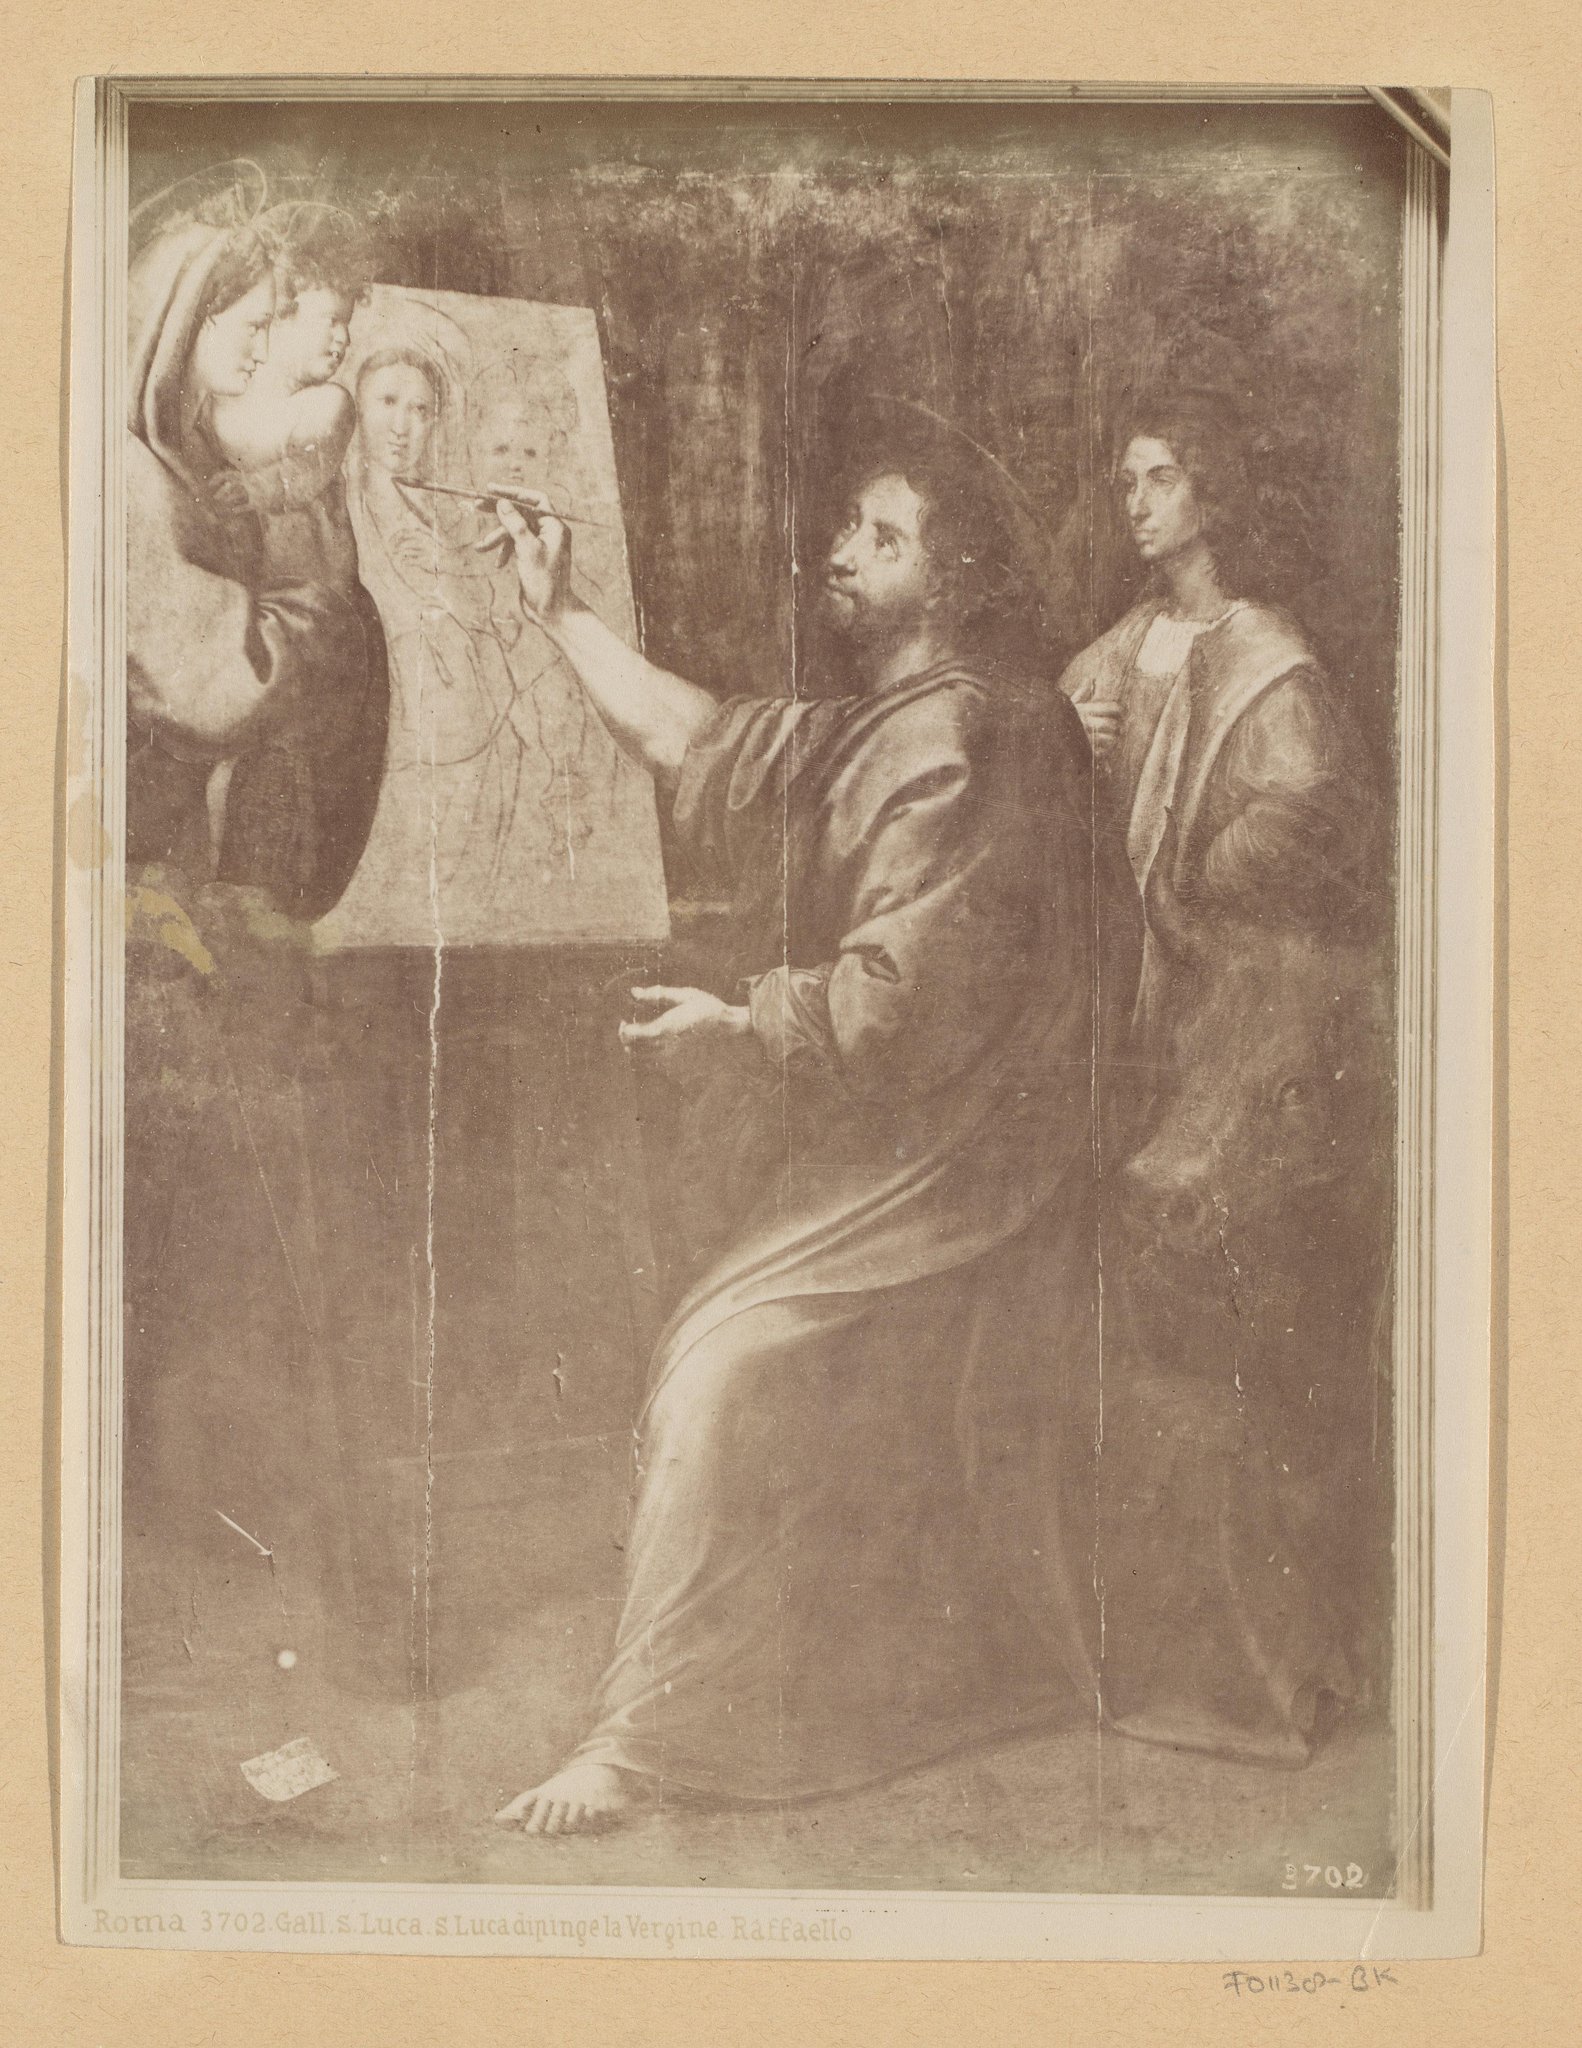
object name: reproduction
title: Fotoreproductie van een schilderij door Rafaël, voorstellend Lucas die Maria schildert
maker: Anonymous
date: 1860-1900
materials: photographic support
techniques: albumen print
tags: st.luke painting or drawing the madonna (i.e. mary and the christ-child), sometimes joseph present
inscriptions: number: ‘3702’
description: Onderdeel van Reisalbum met opnames van kunstwerken en bezienswaardigheden in Italië, Griekenland en Frankrijk.